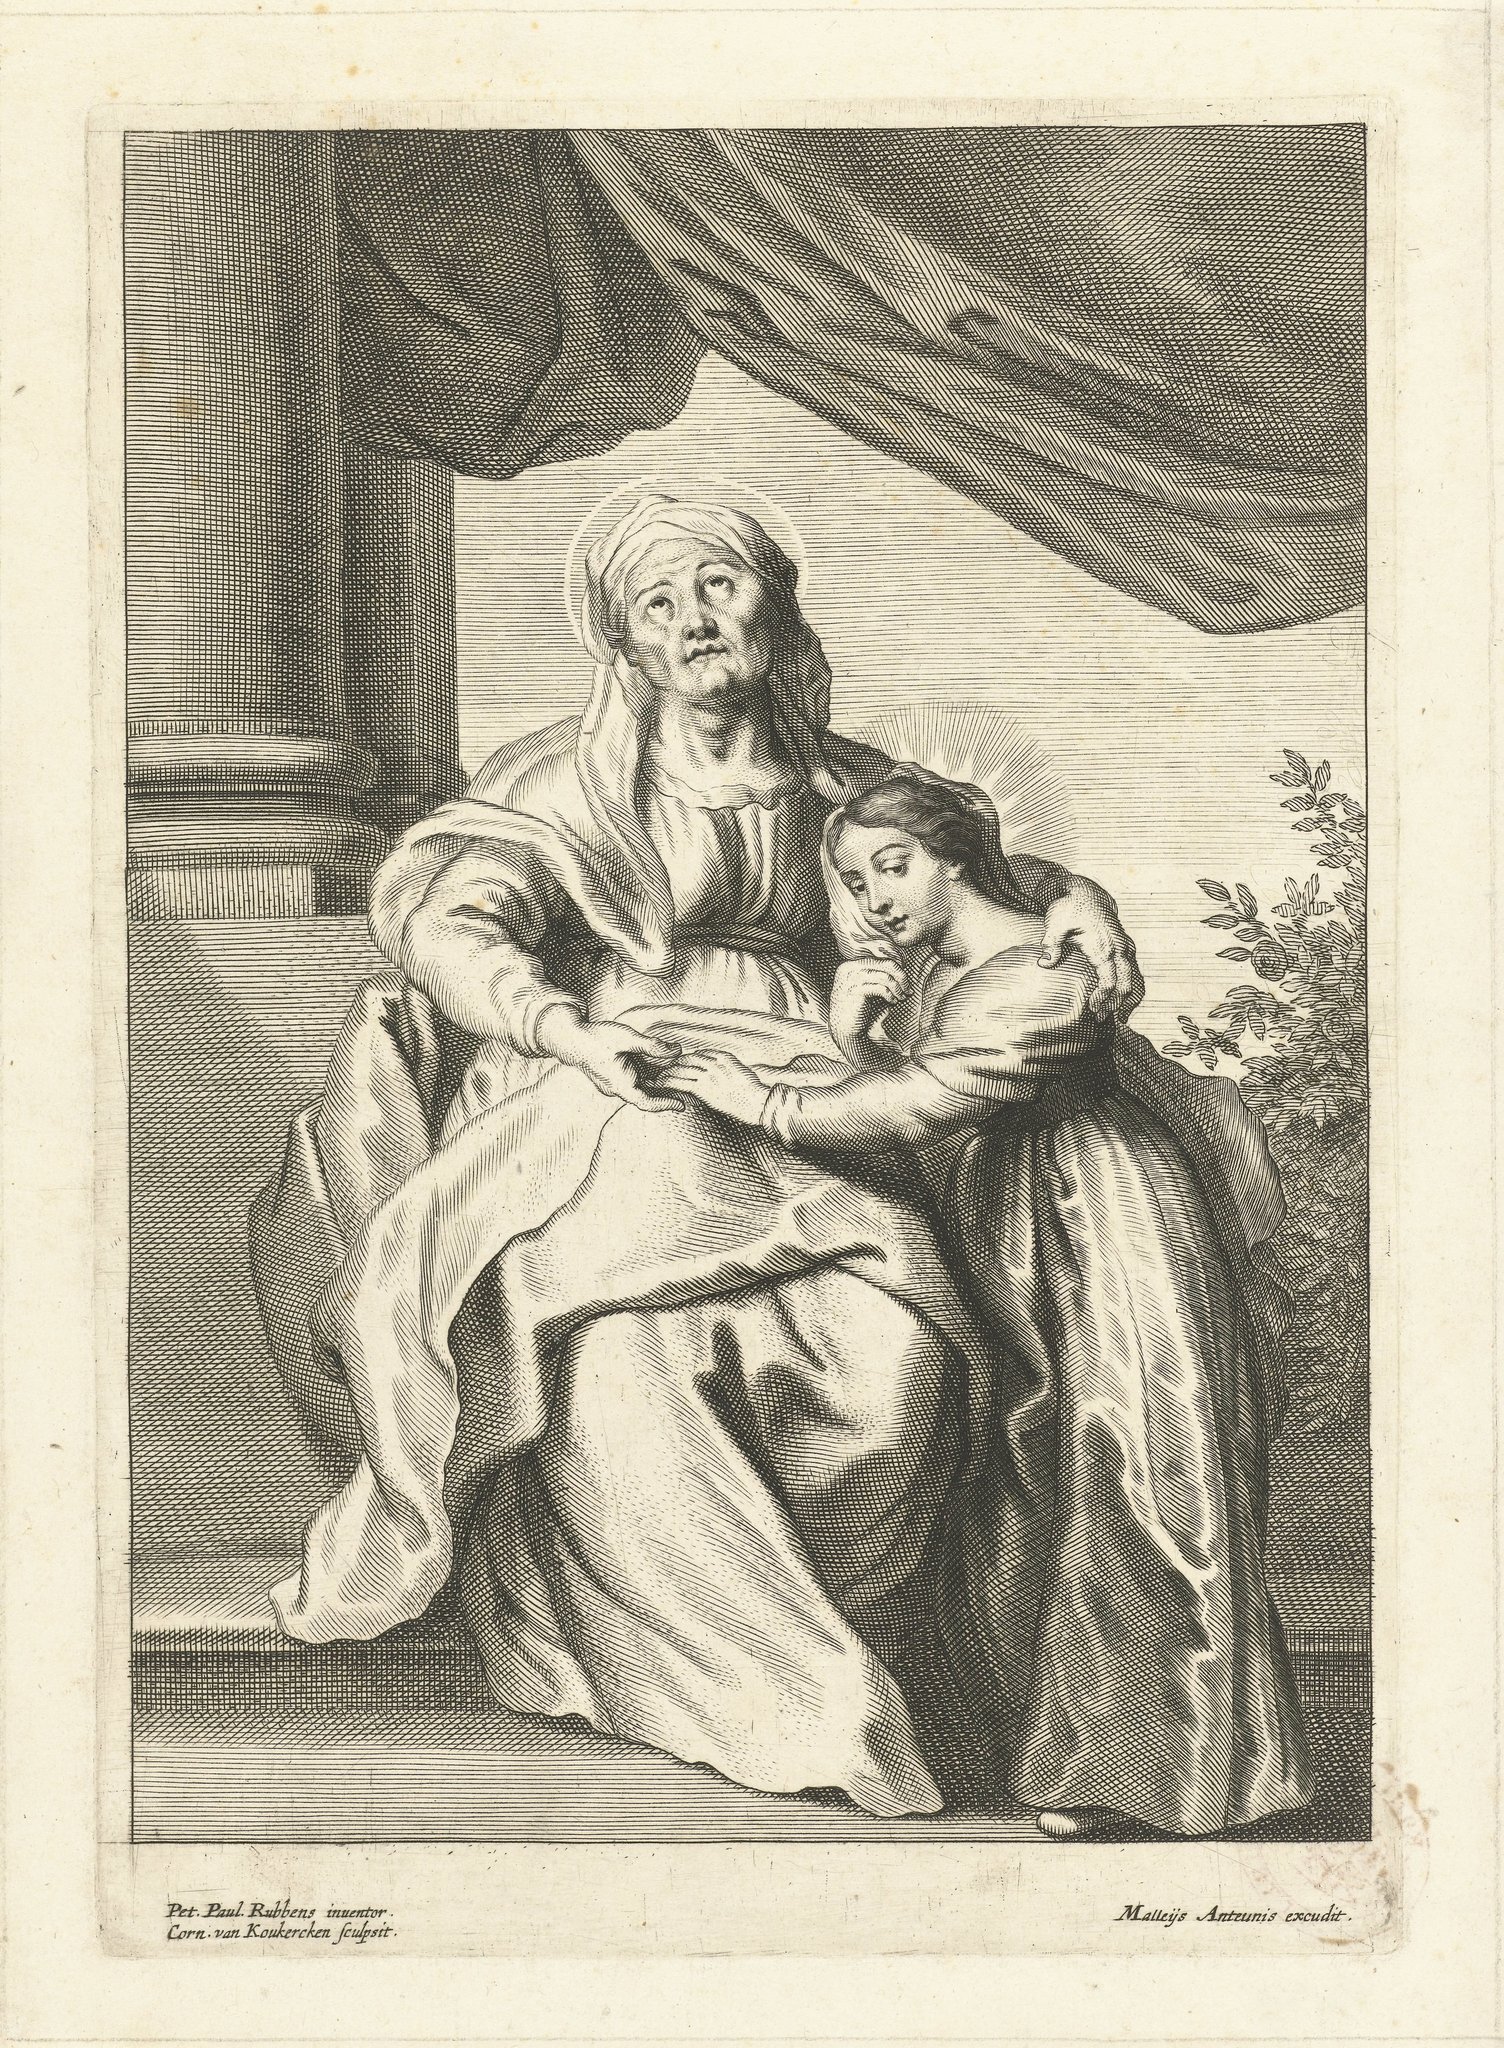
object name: print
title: Anna en Maria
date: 1640-1680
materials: paper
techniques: engraving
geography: southern netherlands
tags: anna, mother of mary; possible attributes: book, christ-child, lily, virgin mary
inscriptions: collector's mark: Lugt 240